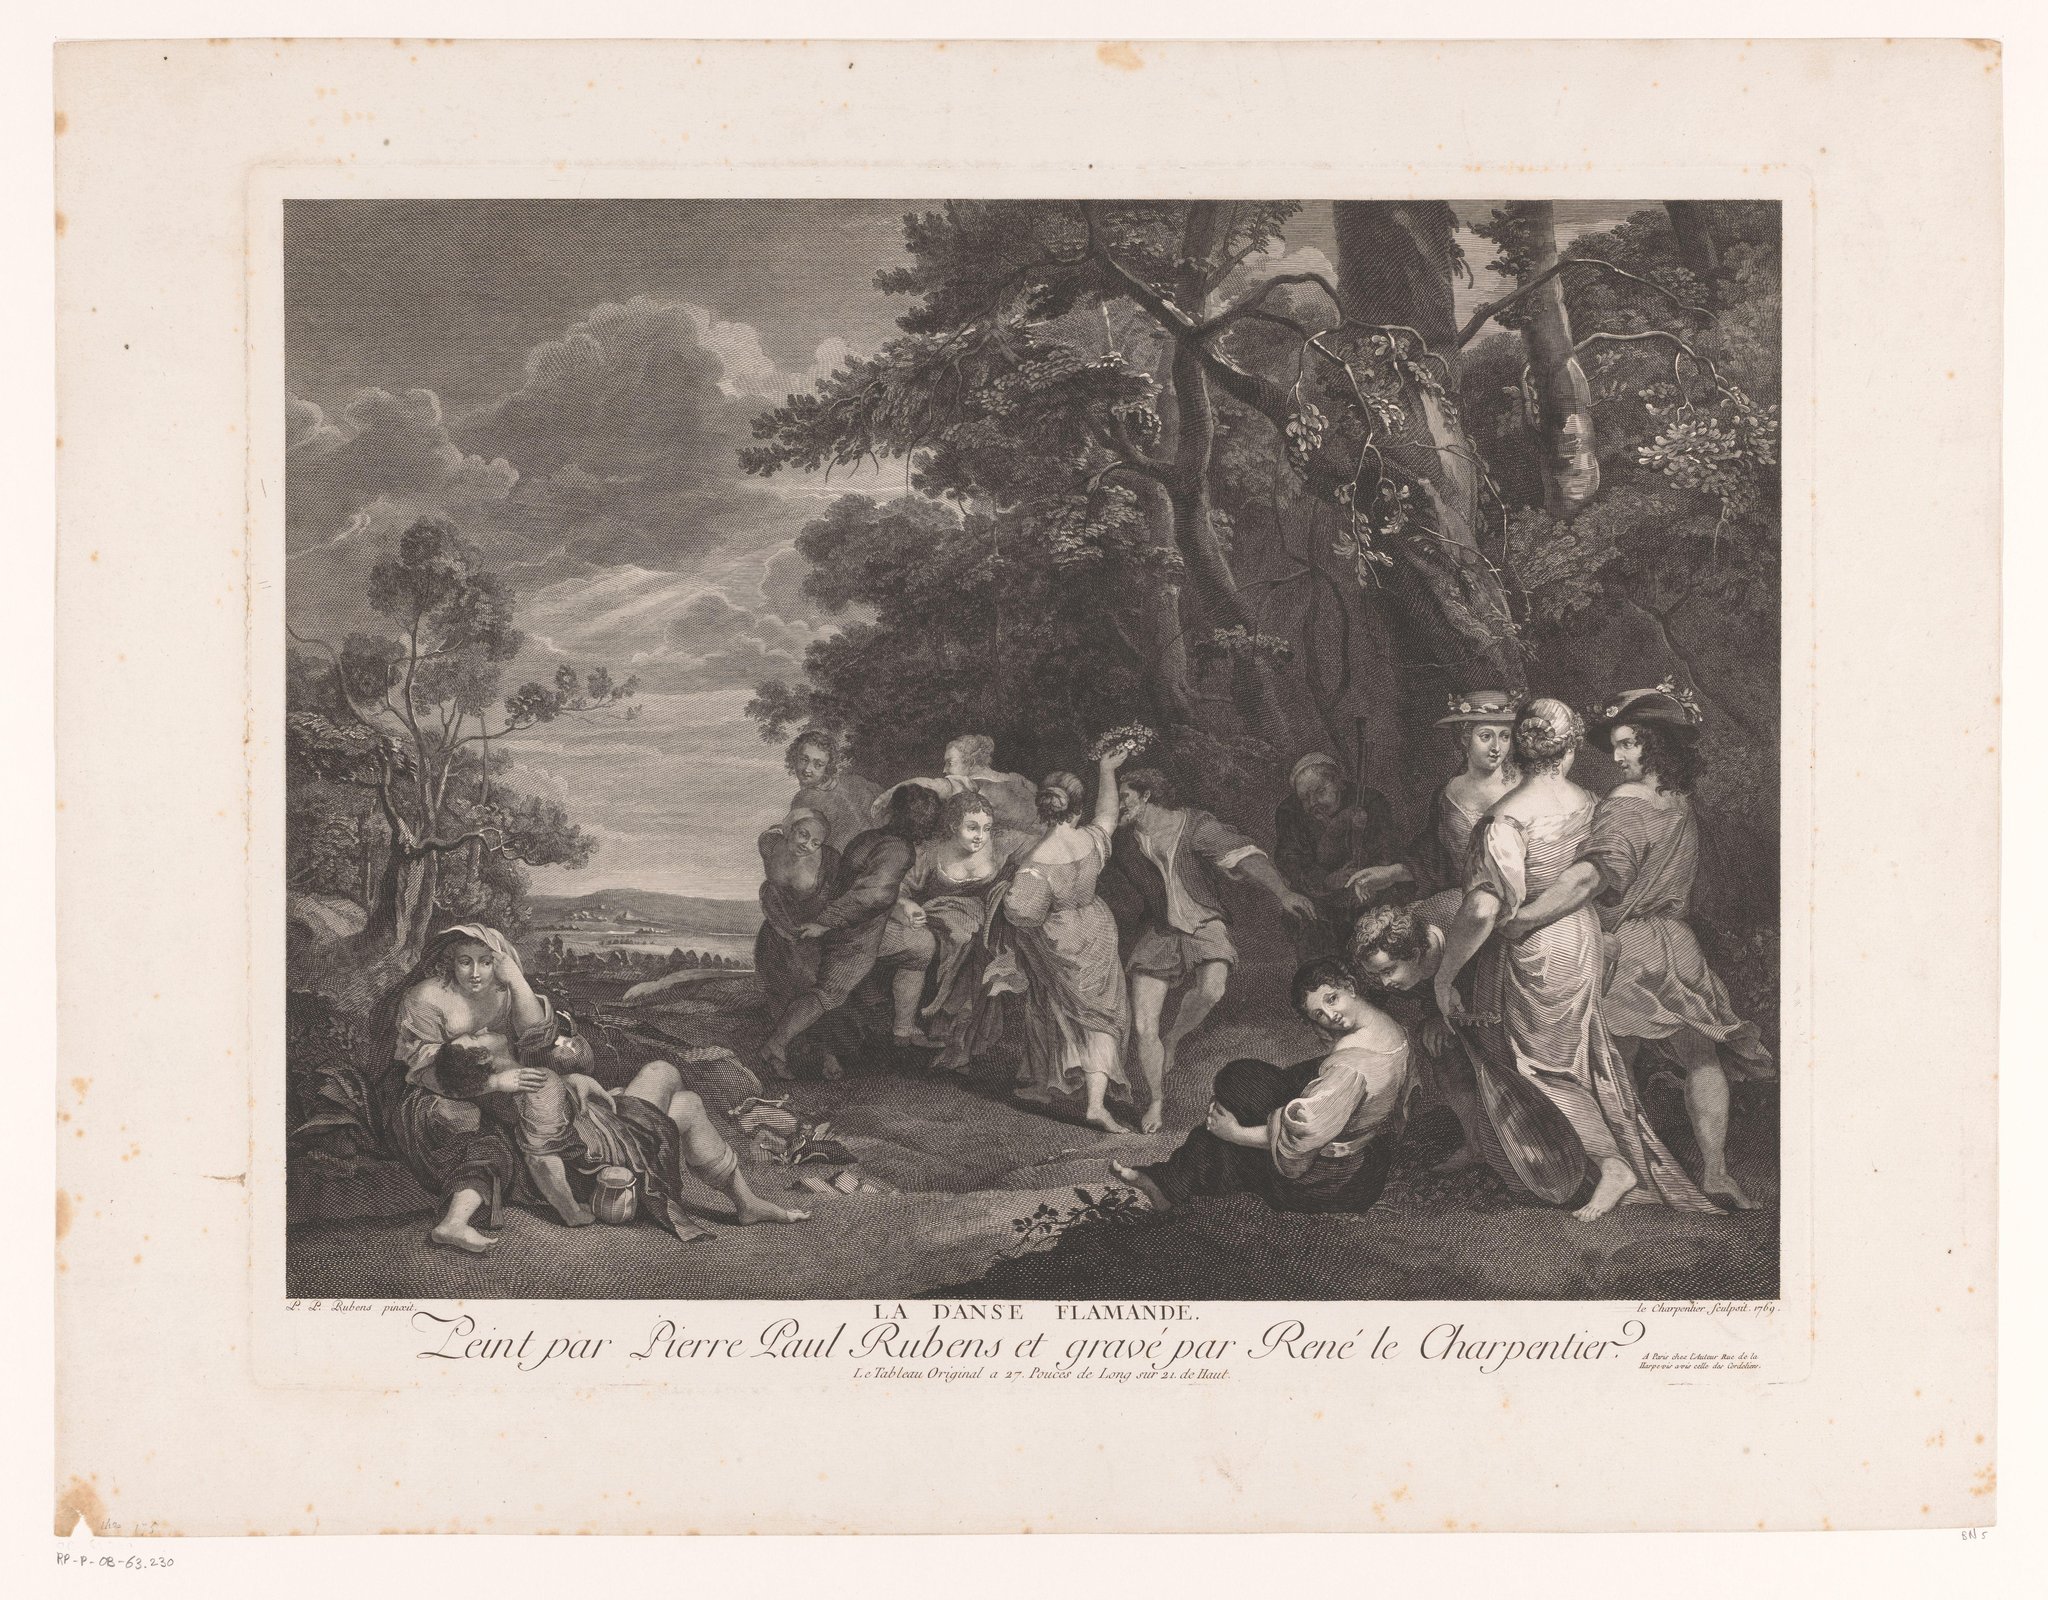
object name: print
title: La Danse Flamande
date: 1769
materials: paper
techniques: engraving, etching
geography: france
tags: group dancing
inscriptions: collector's mark: Lugt 240, inscription: ‘f336,-’